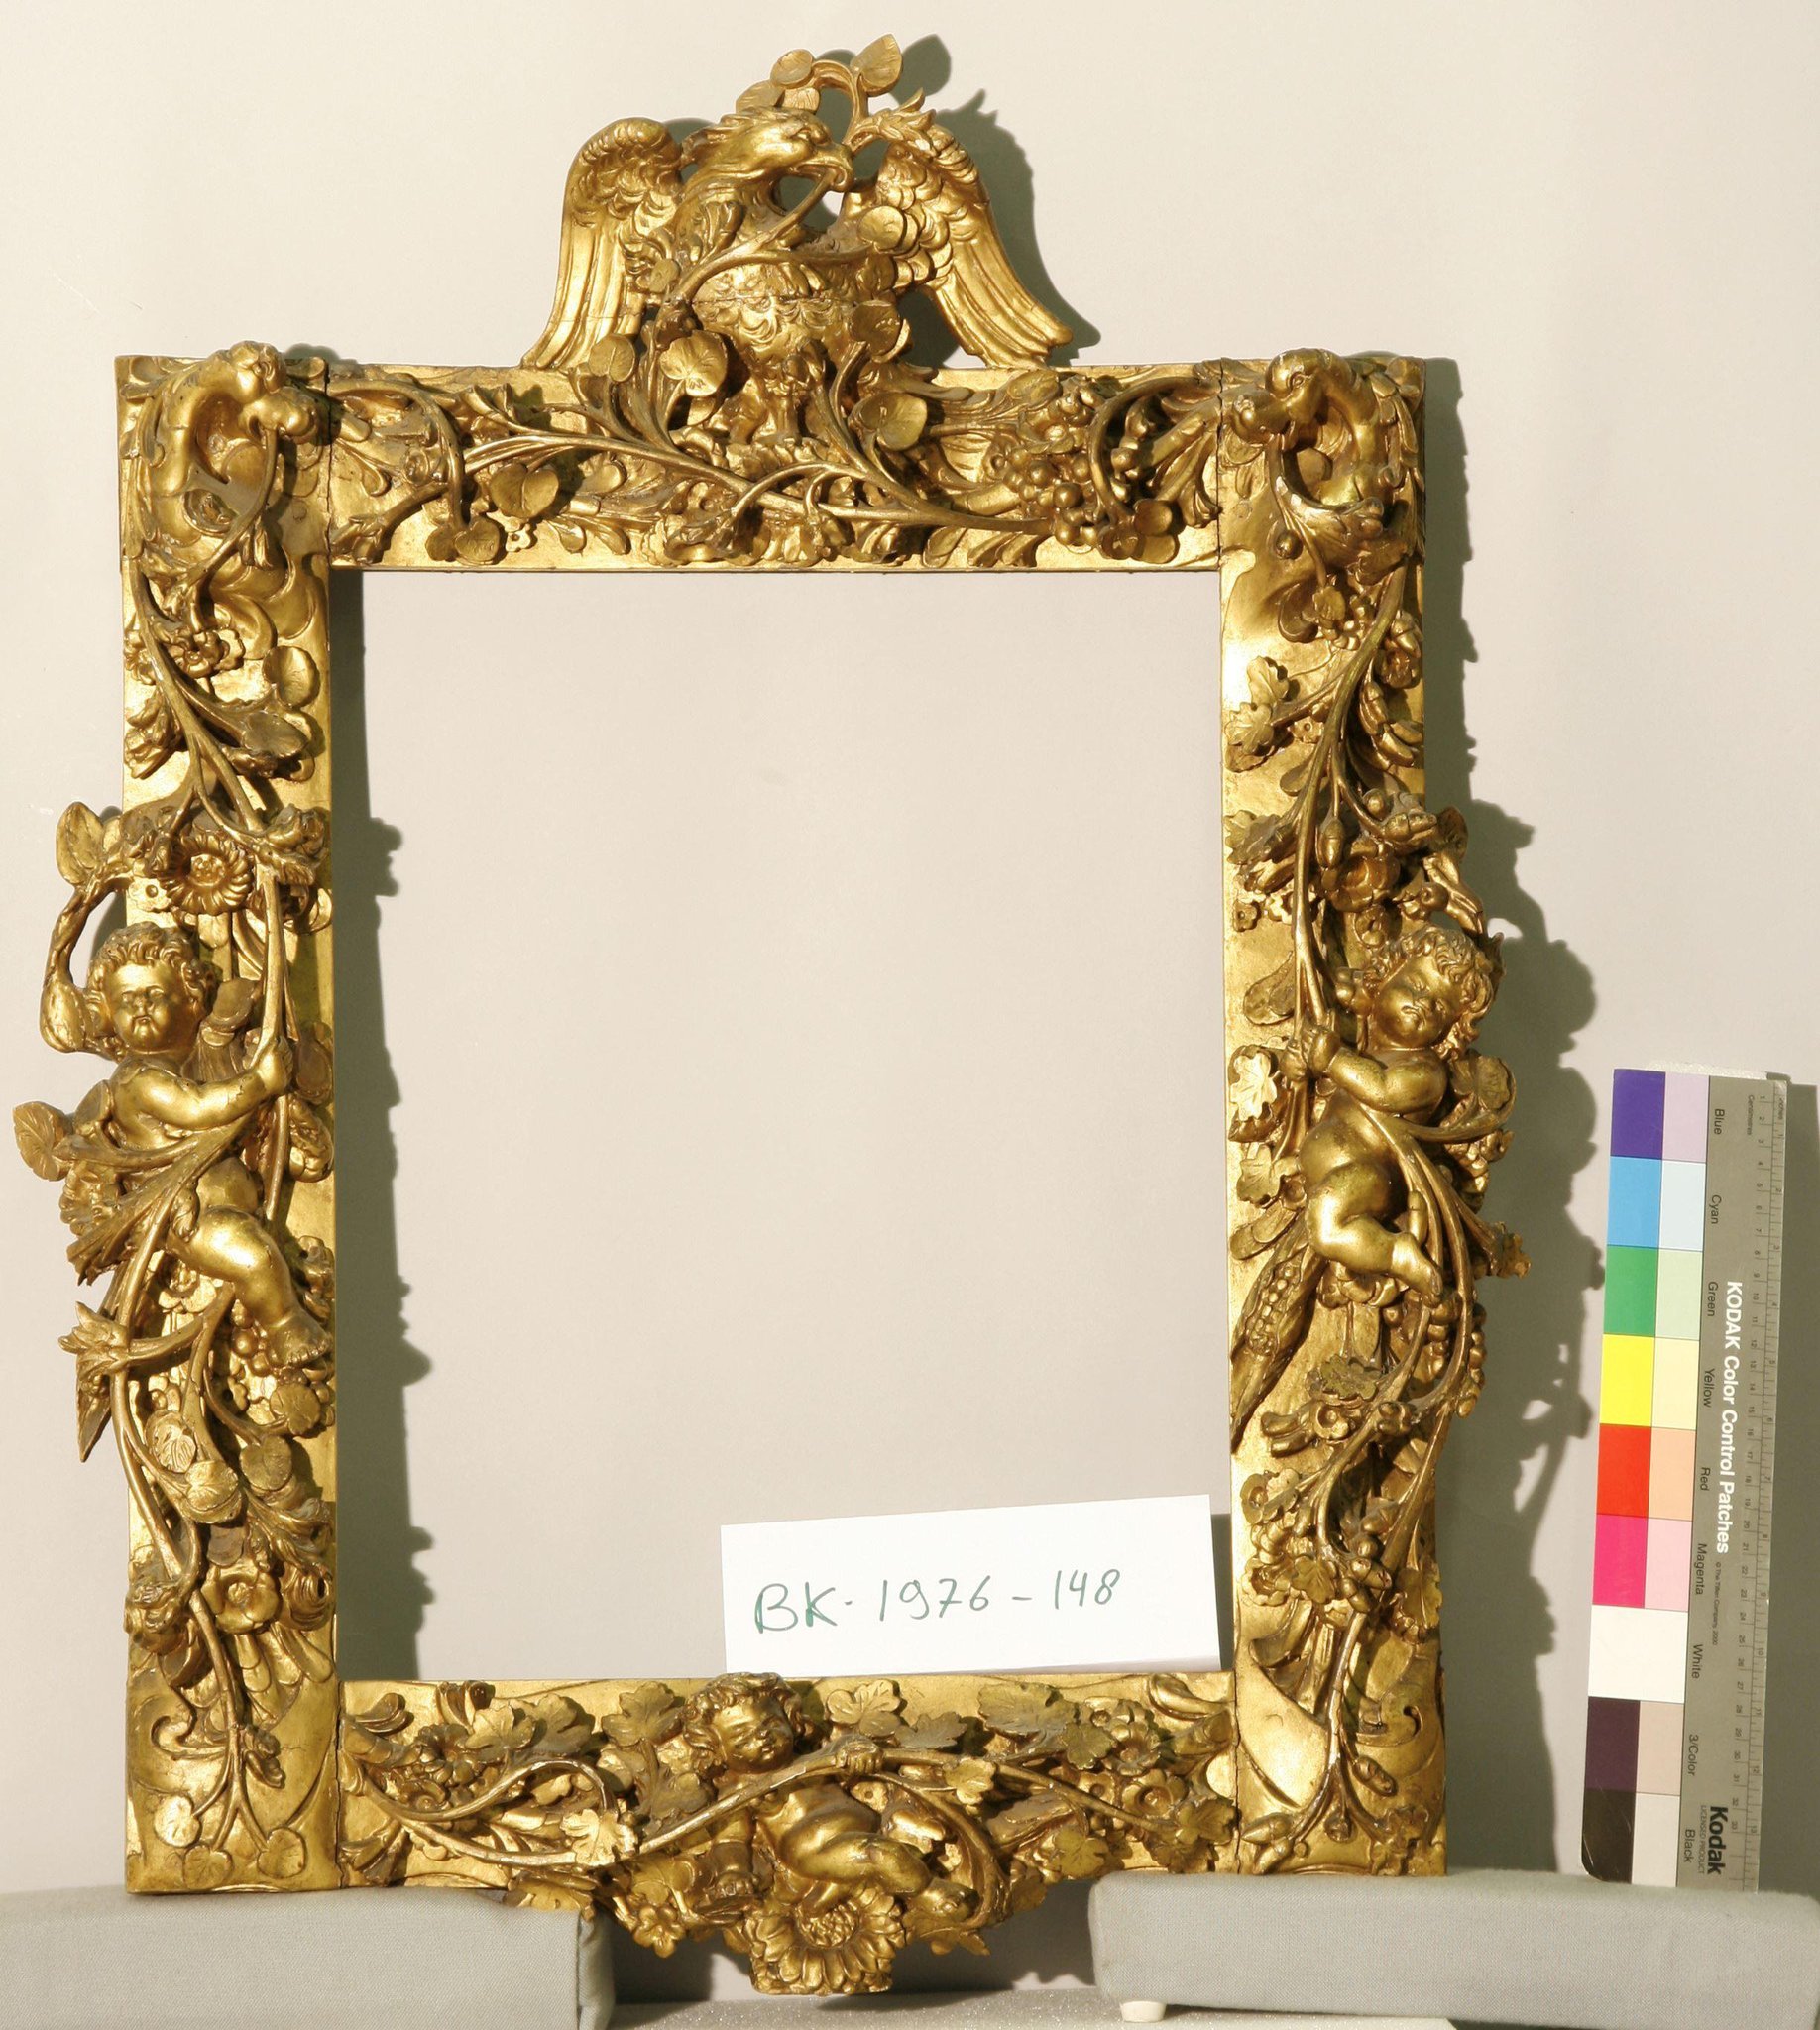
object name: frame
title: Spiegel- of schilderijlijst van verguld notenhout met gesneden versiering van eikentakken, bloemen, een adelaar en drie putti.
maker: Anonymous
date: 1650-1674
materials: gold leaf, wood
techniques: cutting, gilding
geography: northern netherlands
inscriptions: label: ‘oud oranje rijkmuseum etiket’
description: Spiegel- of schilderijlijst van verguld notenhout met rijk gesneden versiering van eikentakken, bloemen, middenboven een adelaar en aan drie zijden een putto. De lijst is koud op elkaar gemonteerd. De zool heeft één ophangoog voor horizontale ophang. De conditie van de lijst is goed: wel zijn enkel delen van de overkragende ornamentiek afgebroken.